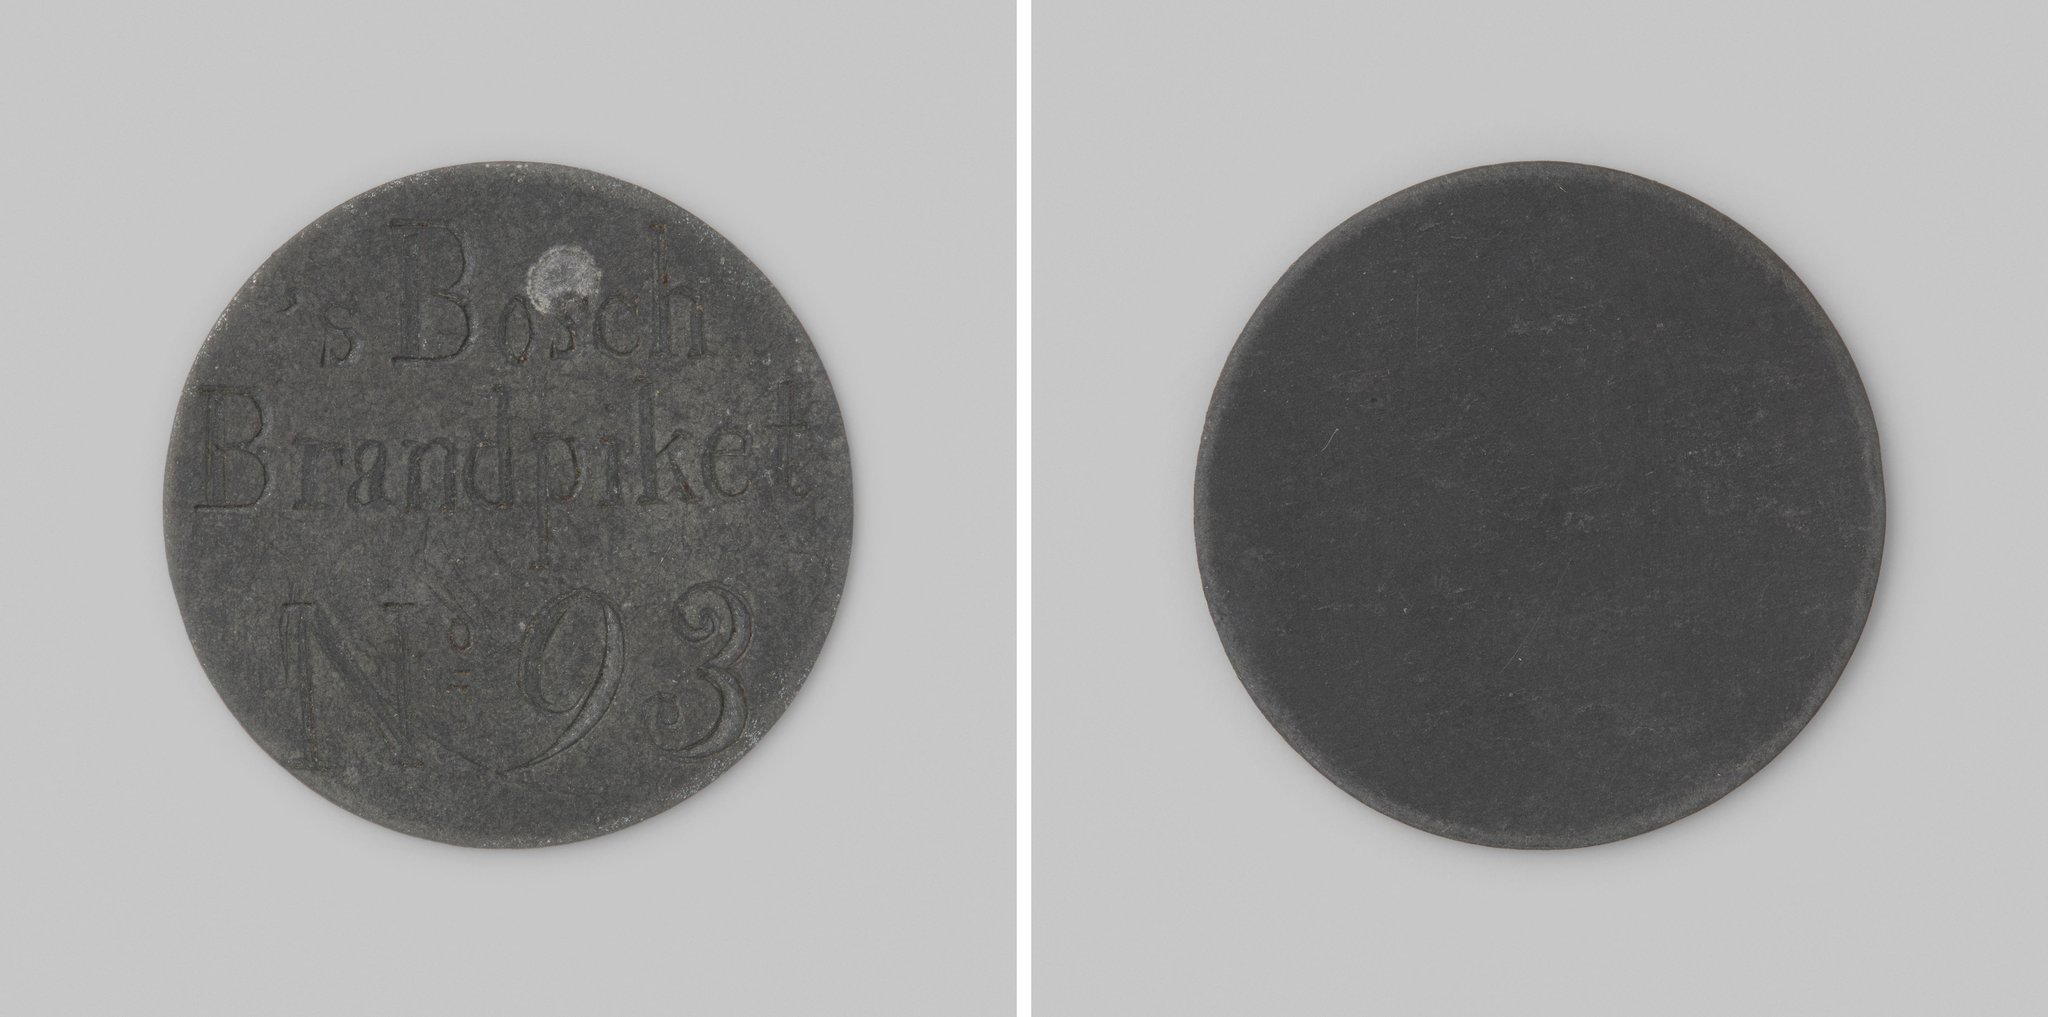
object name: medal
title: Presentiepenning van de schutterij en brandpiket te 's-Hertogenbosch met gegraveerd nummer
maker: Anonymous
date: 1800-1899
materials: metal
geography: den bosch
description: Metalen penning aan voorzijde gegraveerd en keerzijde glad.